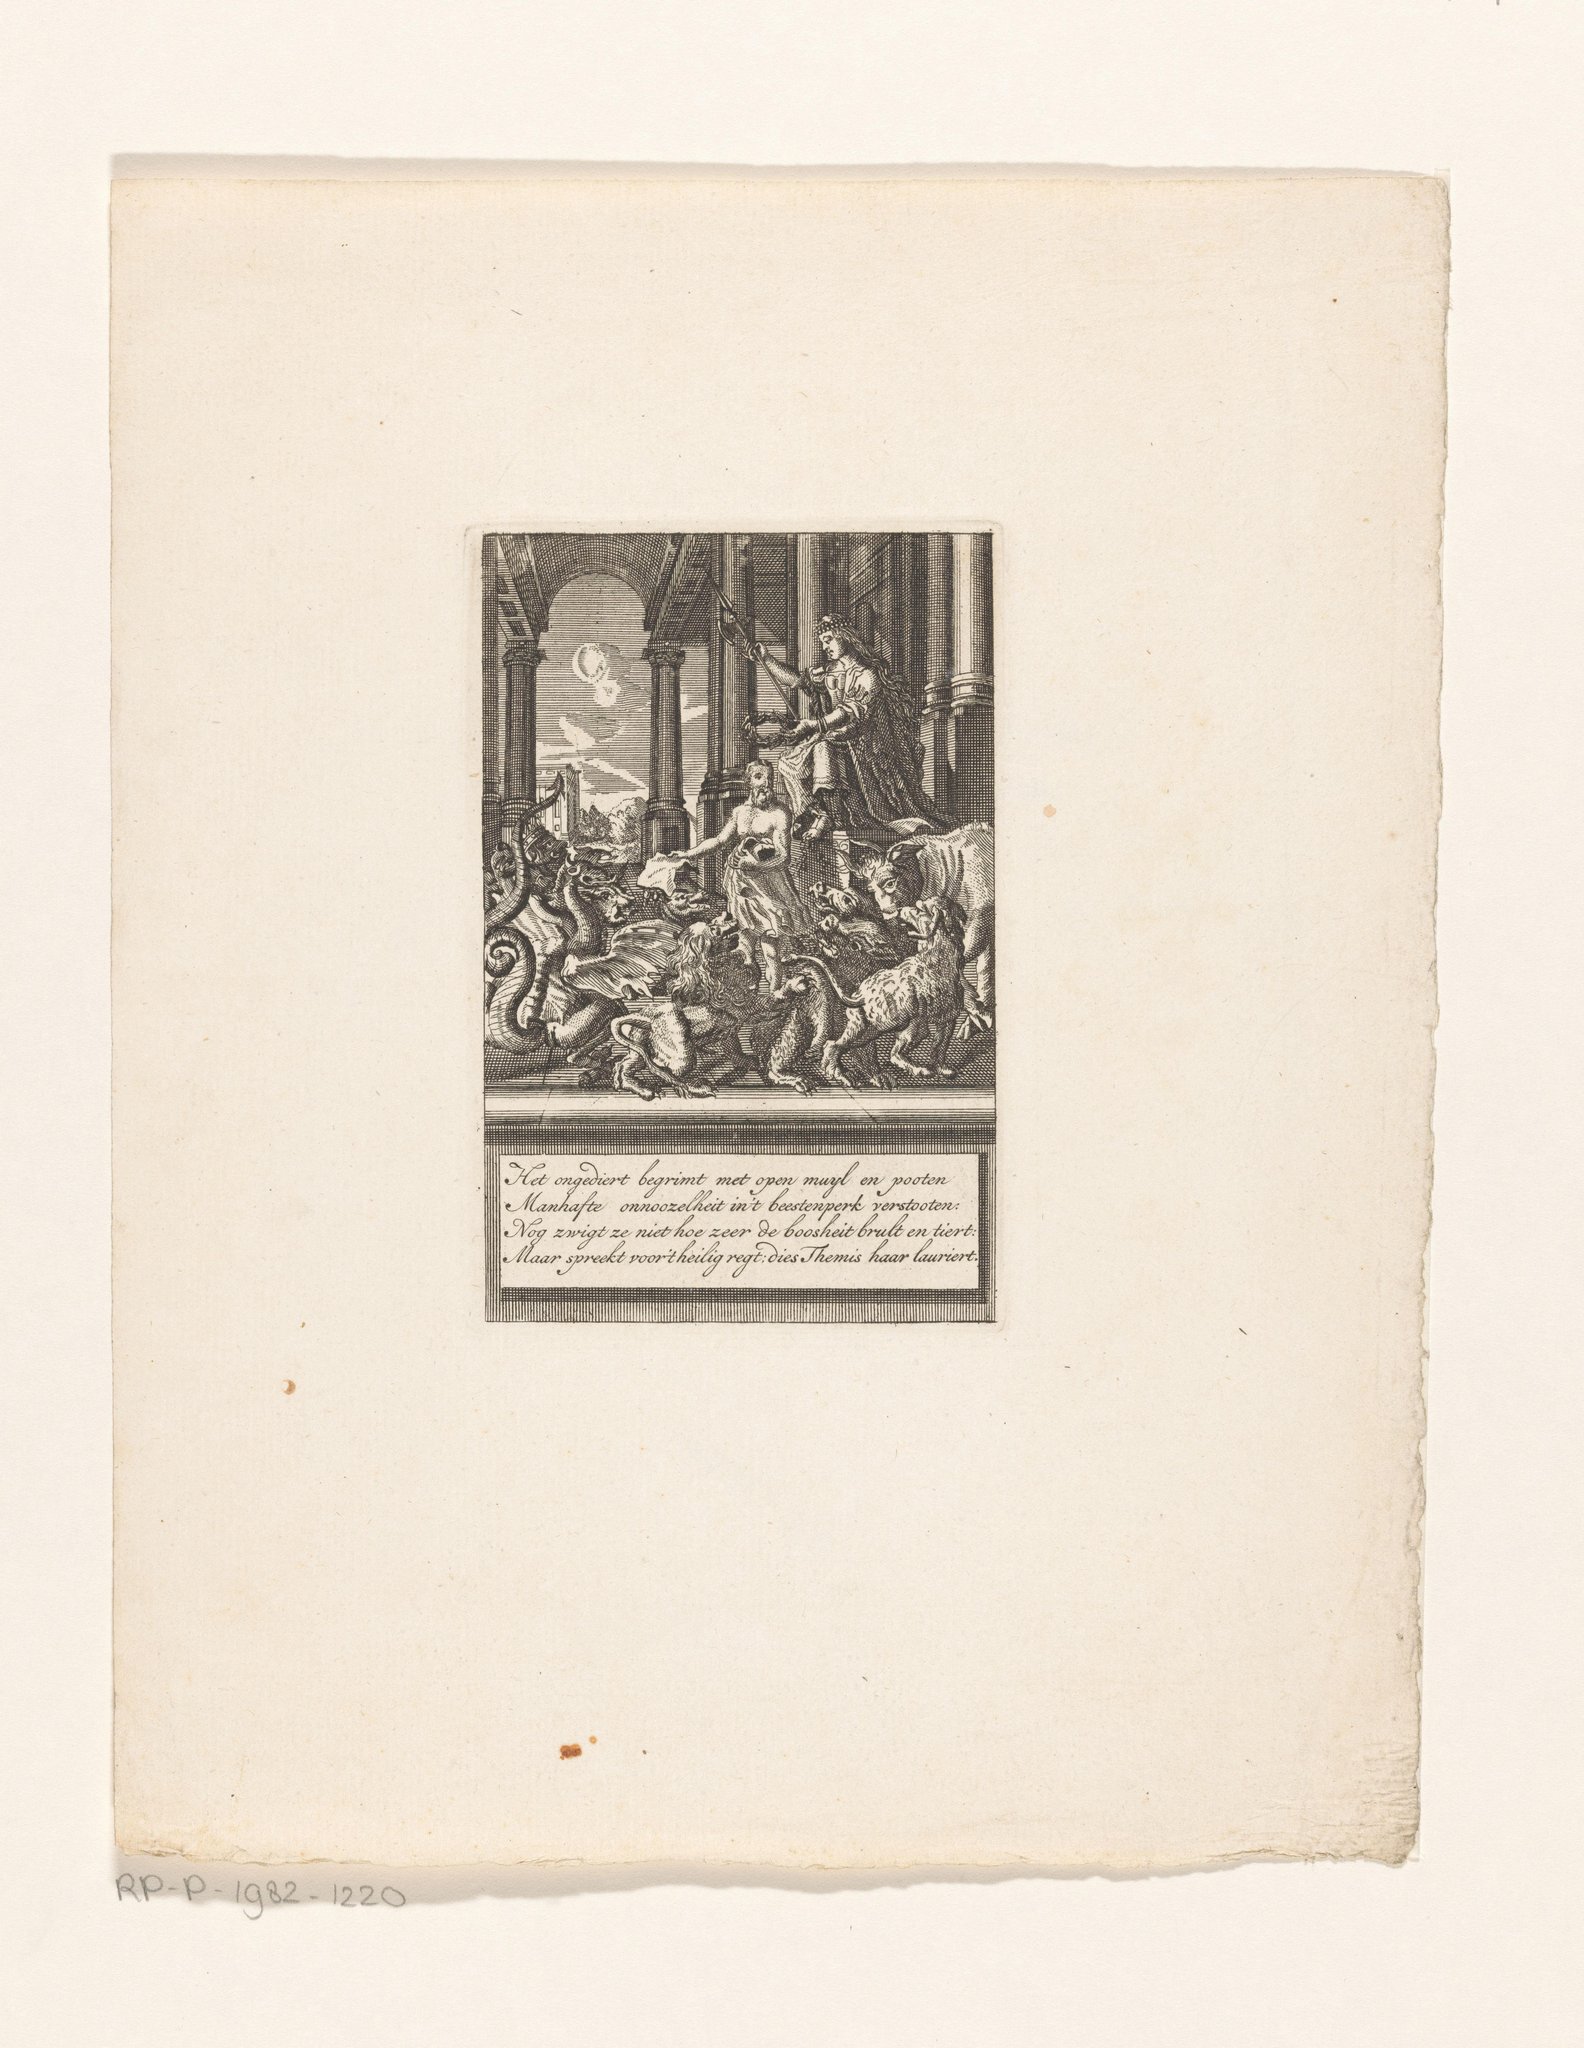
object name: book illustration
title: Moedige Onnozelheid door Themis gekroond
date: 1707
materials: paper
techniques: engraving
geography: rotterdam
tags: the hague, johan van oldenbarnevelt, themis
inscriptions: collector's mark: Lugt 2760, collector's mark: Lugt 2228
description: Wilde dieren bedreigen Palamedes (of Johan van Oldenbarnevelt), de personificatie van moedige onnozelheid, die een document met zegels toont. Themis, de godin van het recht, bekroont hem met een lauwerkrans. Onder de voorstelling een vierregelige Nederlandse vers.